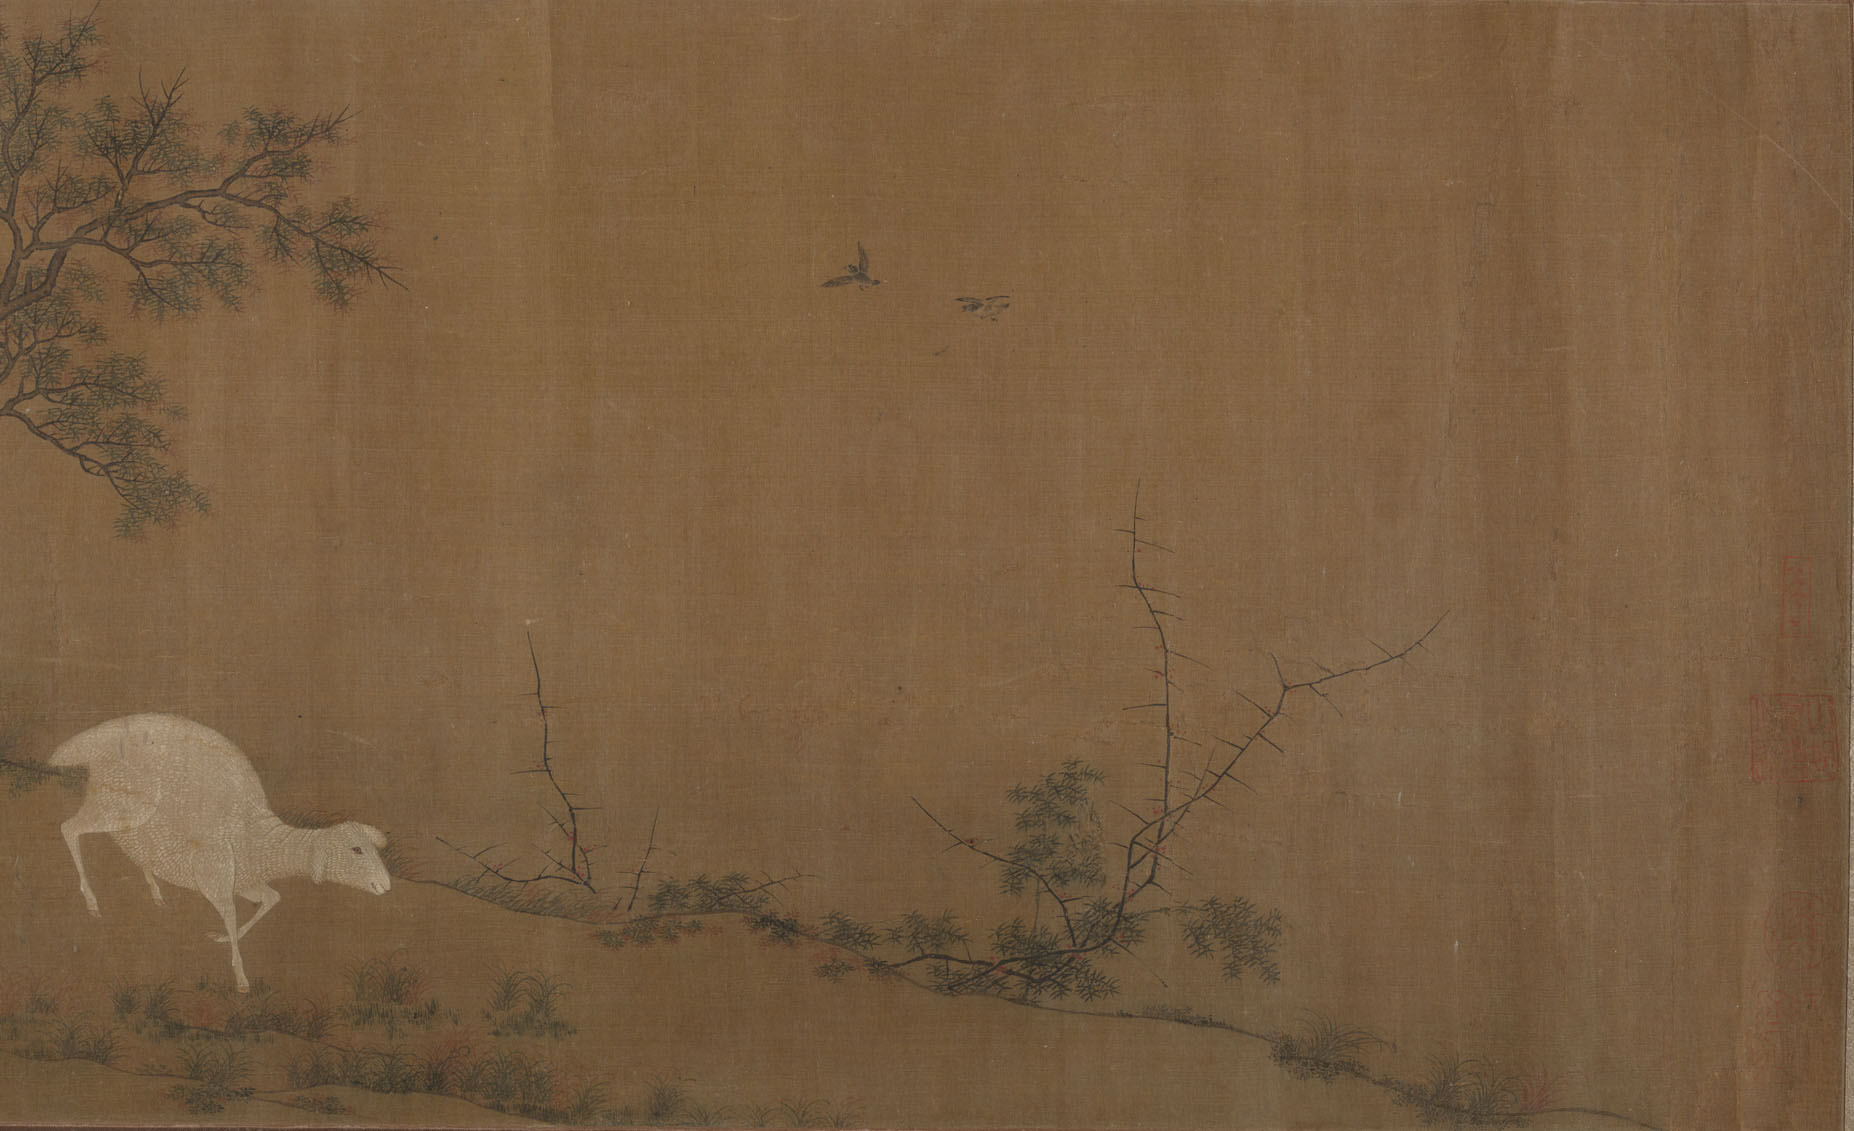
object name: handscroll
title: Landscape with goats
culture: chinese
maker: unidentified artist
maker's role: artist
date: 1368-1644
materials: ink, silk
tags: goats,landscapes